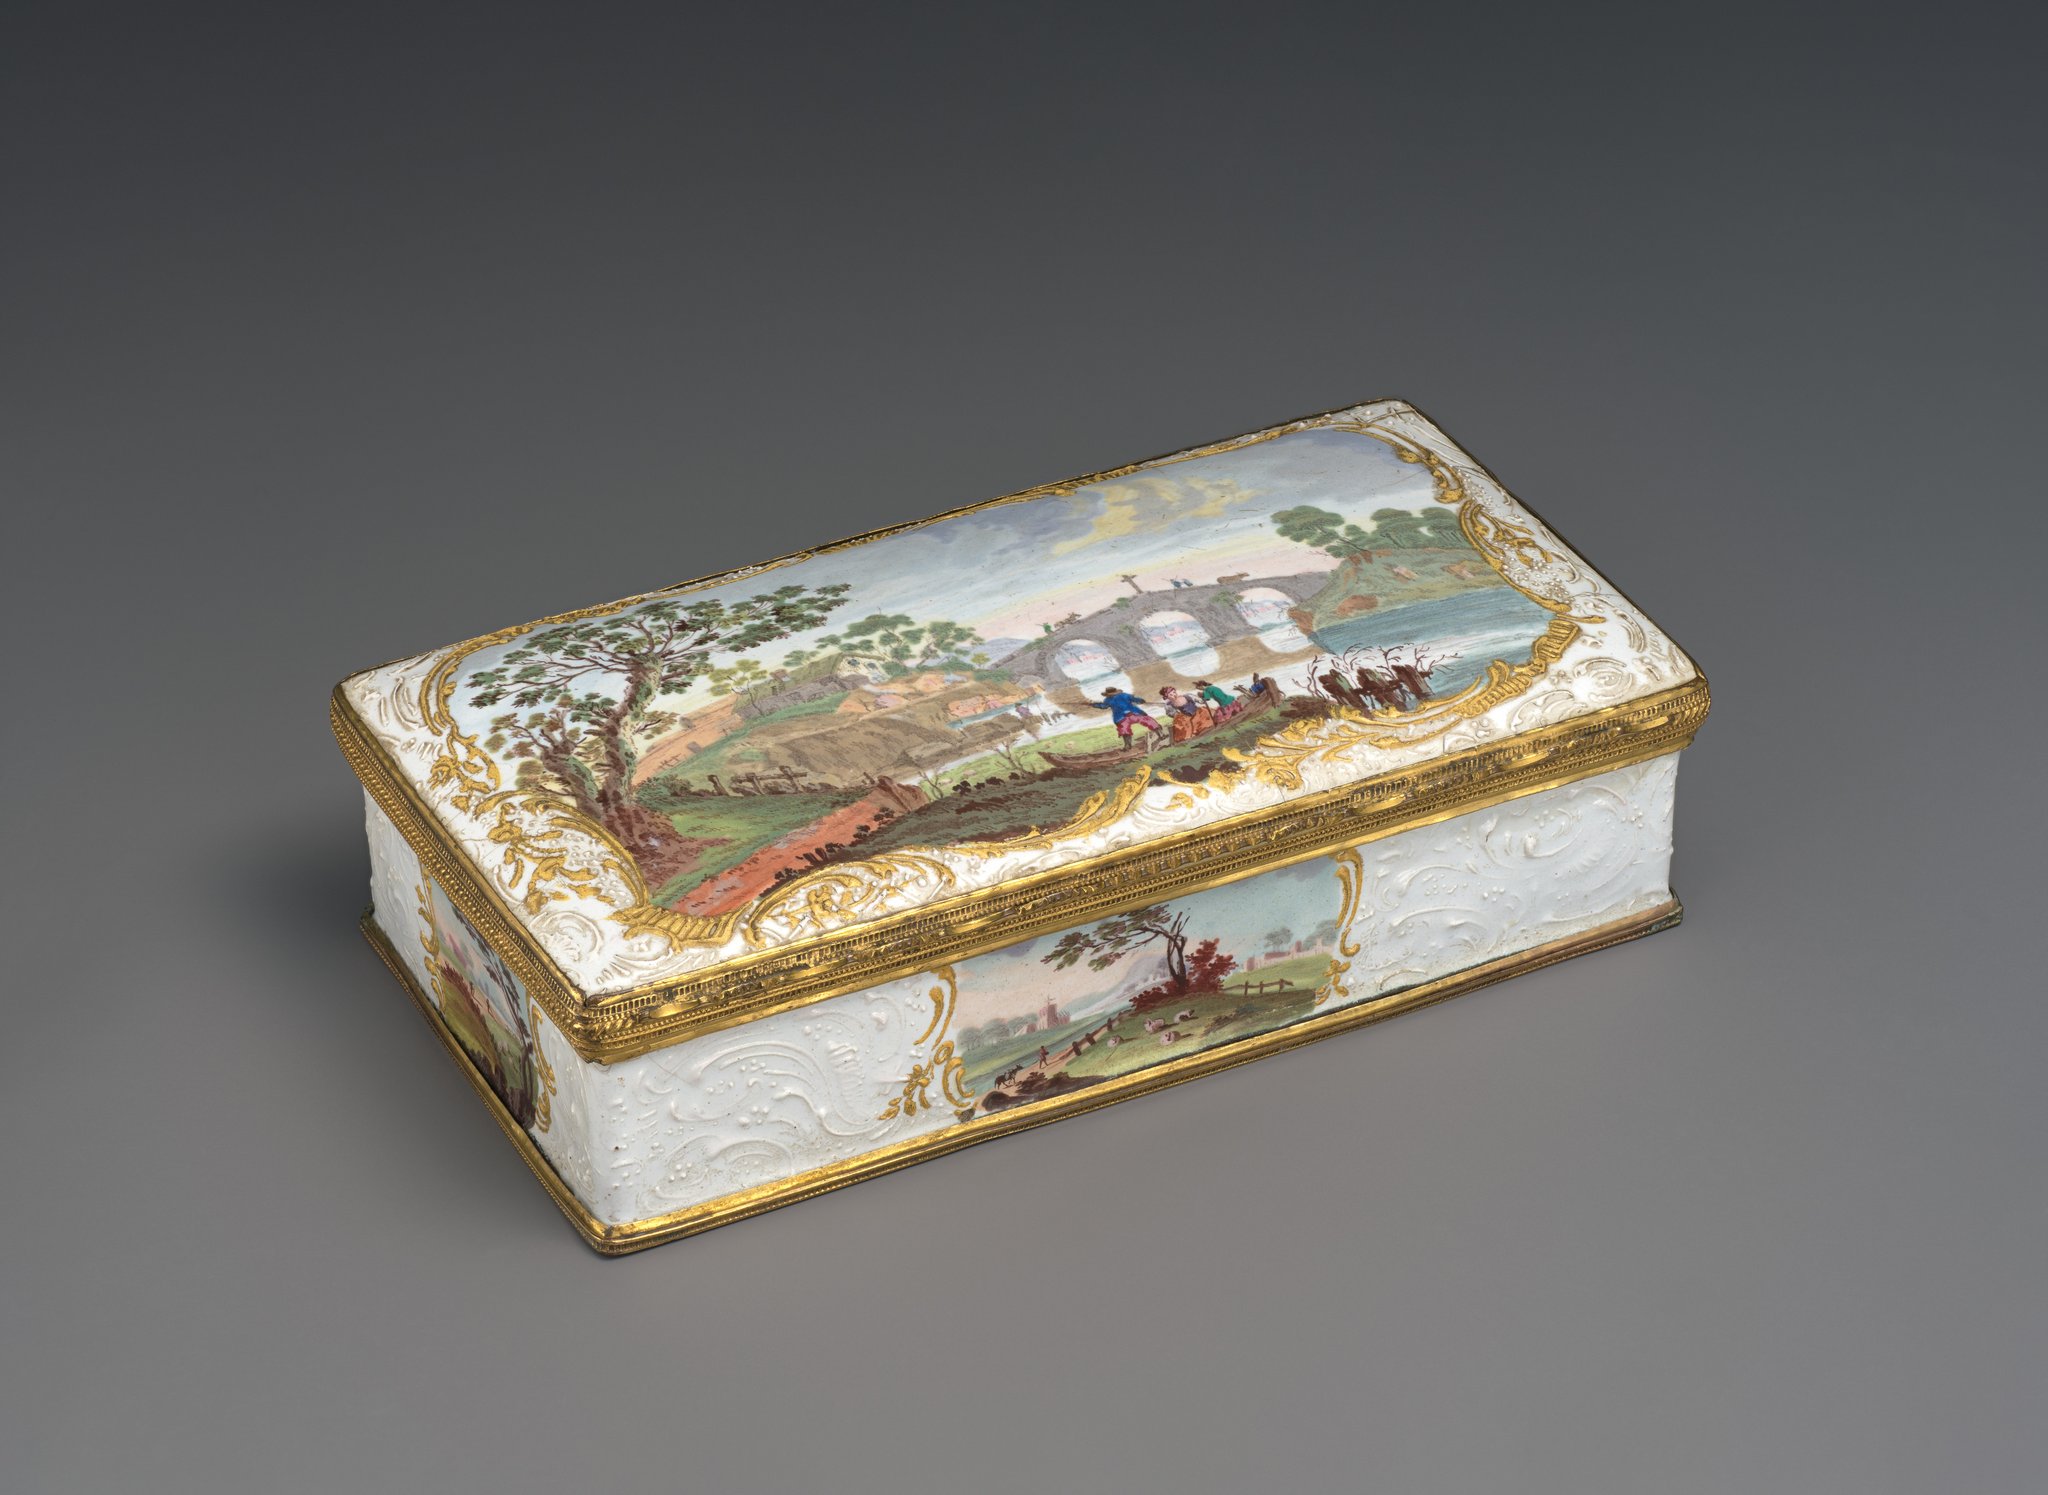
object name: box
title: Toilet box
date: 1765-1770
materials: copper, enamel